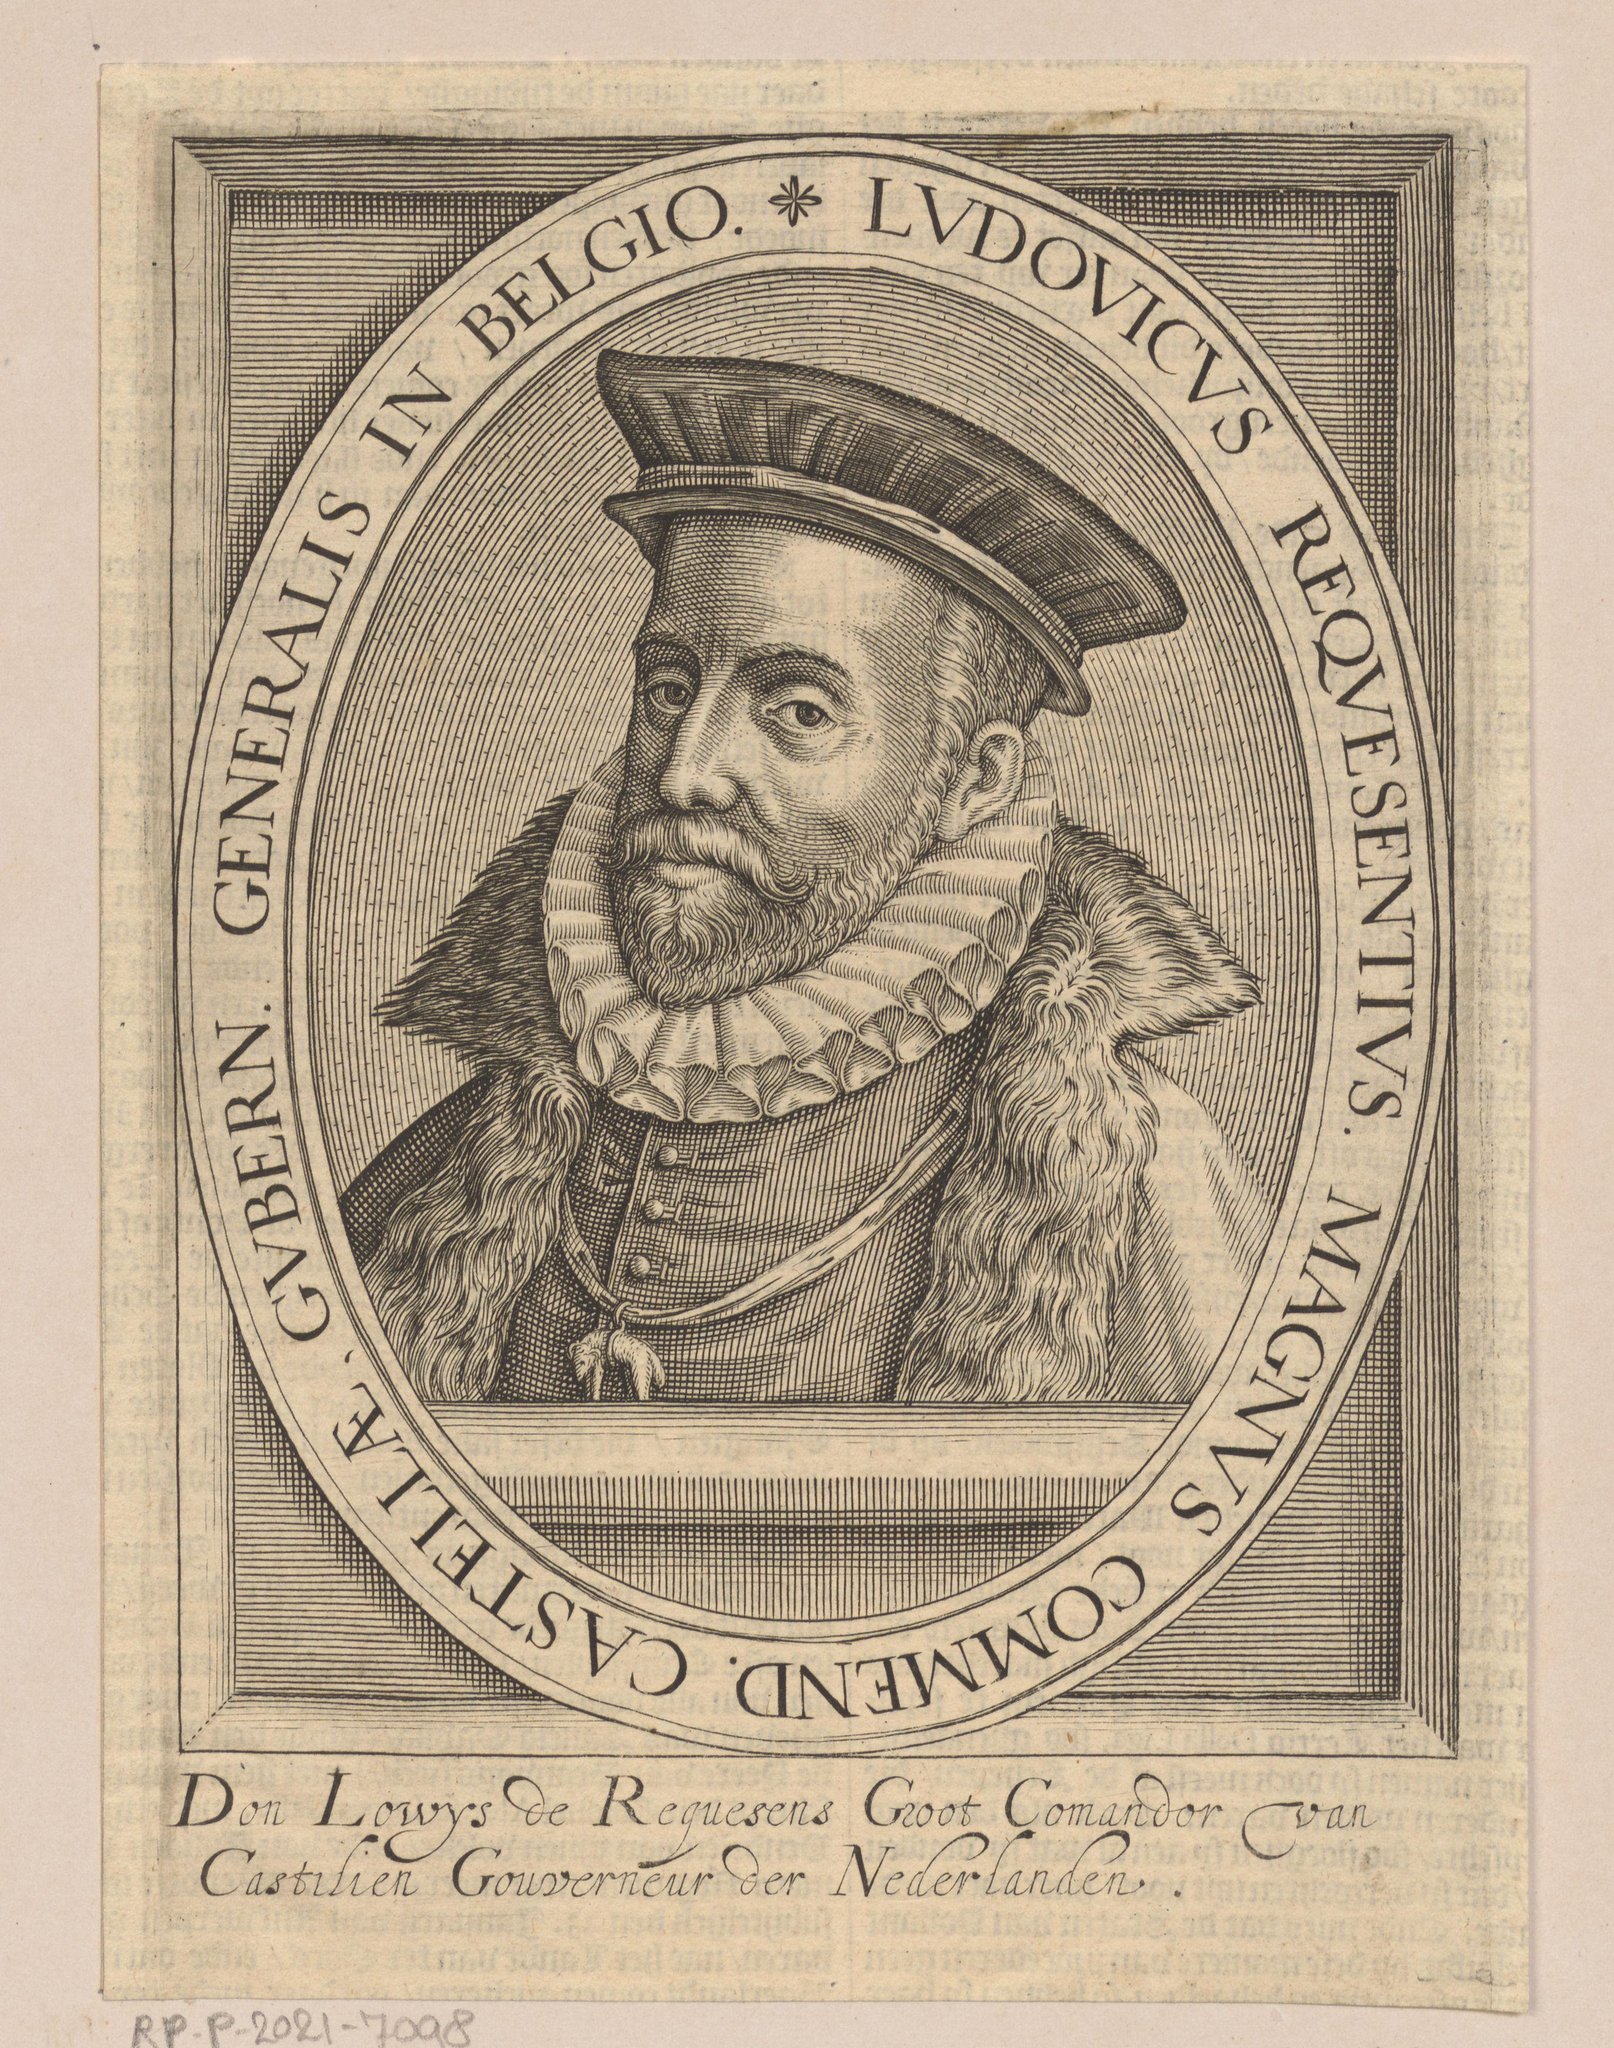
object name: book illustration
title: Portret van Luis de Zúñiga y Requesens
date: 1614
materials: paper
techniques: engraving, letterpress printing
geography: the hague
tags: mayor, luis de zúñiga y requesens, historical persons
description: Prent uit: Meteren, Emanuel van. Emanuels Van Meteren Historie der Neder-landscher ende haerder Na-buren oorlogen ende geschiedenissen (...). Den Haag: Hillebrant Jacobsz. van Wouw I, 1614.